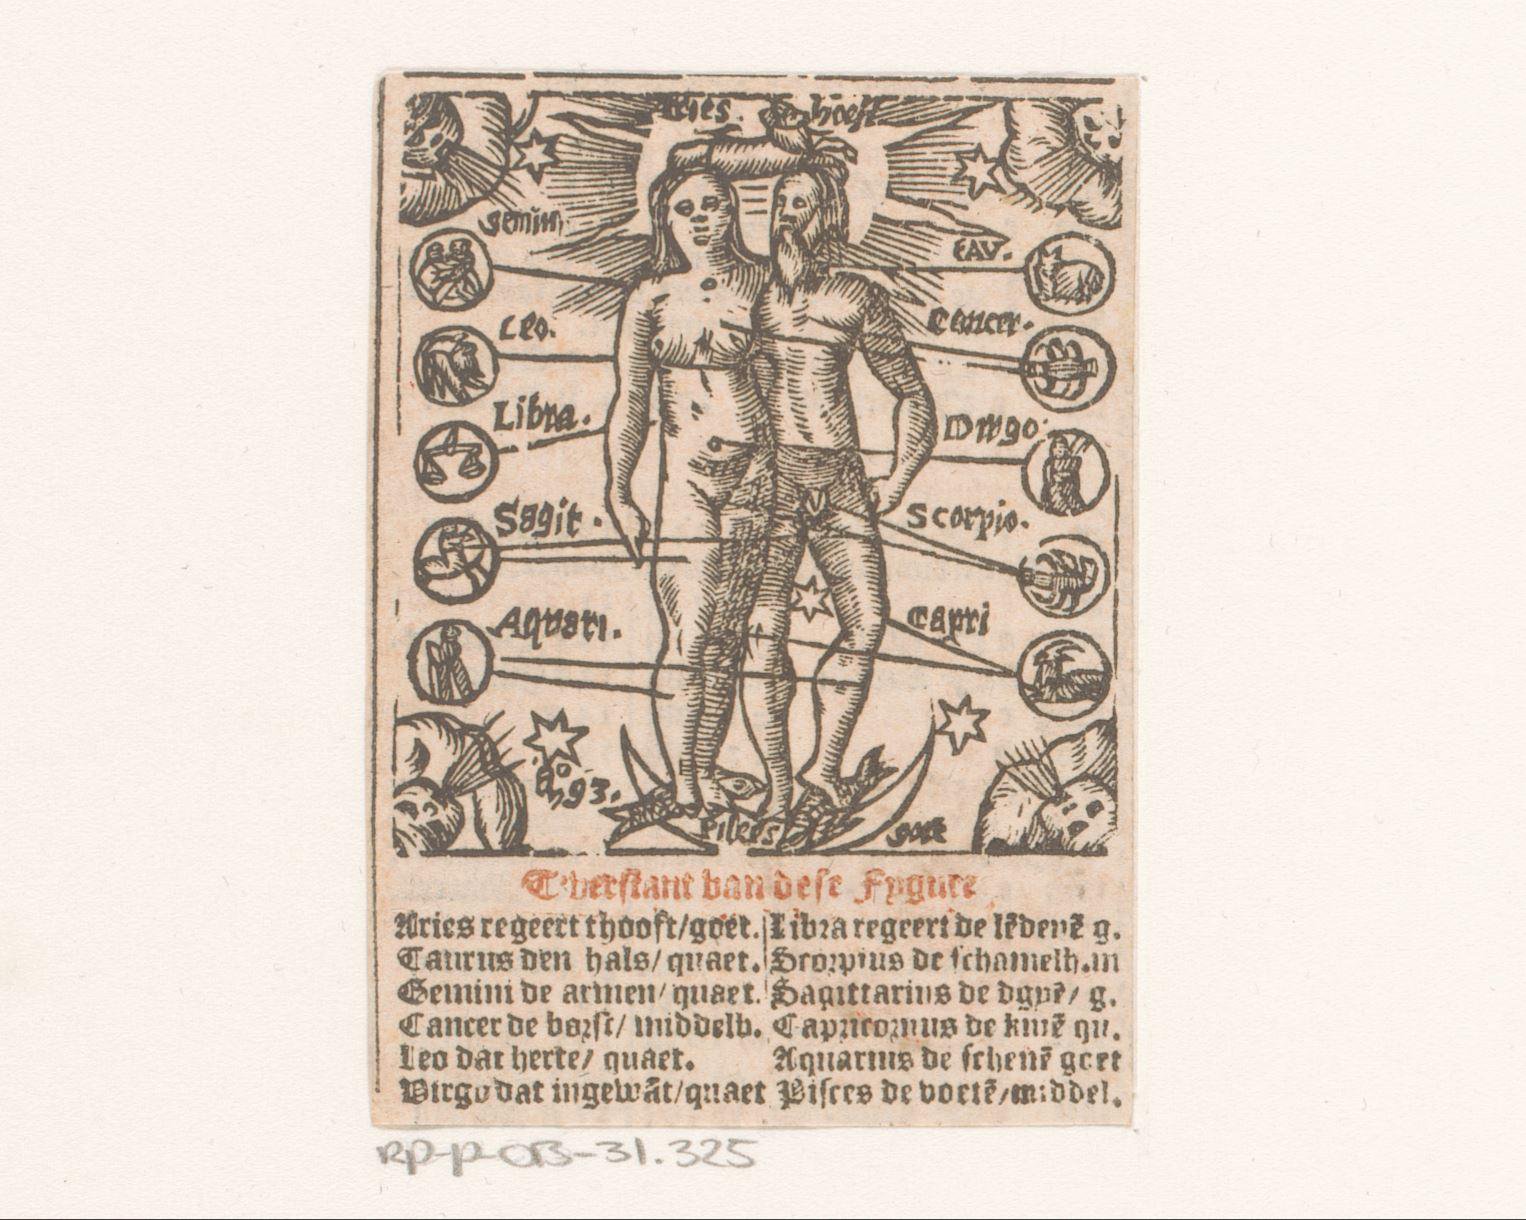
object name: print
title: Menselijk lichaam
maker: Anonymous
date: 1600-1699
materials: paper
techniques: letterpress printing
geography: netherlands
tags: zodiacal man; zodiac combined with parts of the human body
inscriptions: collector's mark: Lugt 240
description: Het vooraanzicht van twee menselijke lichamen met afbeeldingen van de tekens van de dierenriem die door lijnen verbonden zijn met bepaalde delen van het lichaam. In de ondermarge twee kolommen met elk zes regels Nederlandse tekst.